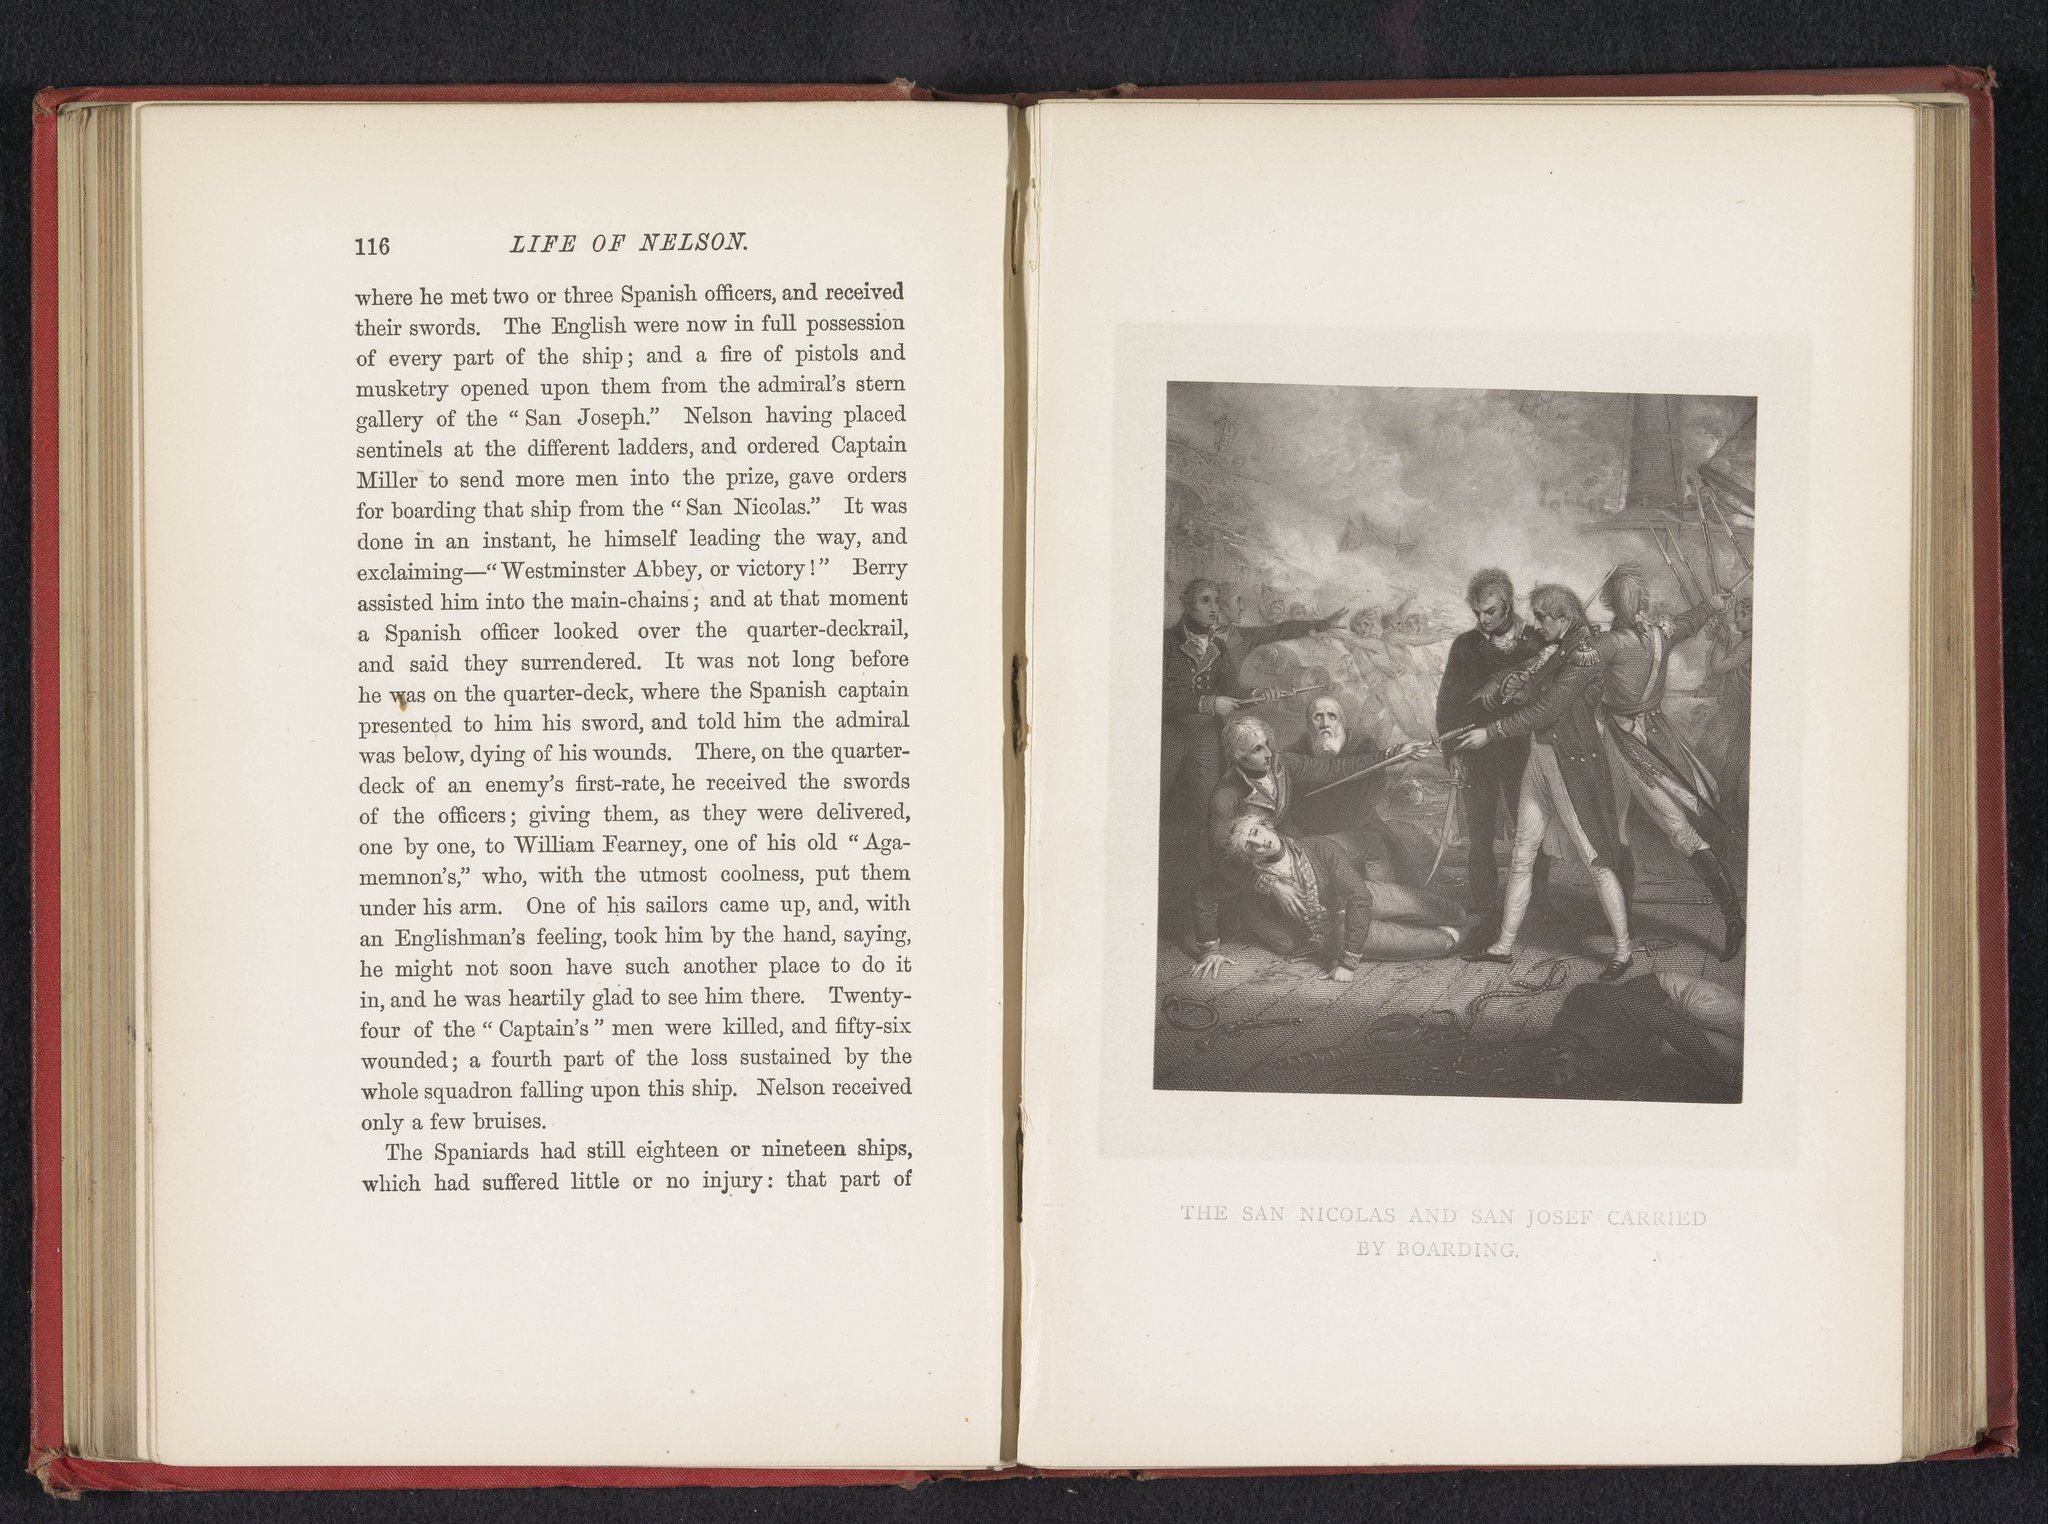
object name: page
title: Fotoreproductie van een prent van vermoedelijk de zeeslag bij Kaap Sint-Vincent in 1797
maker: Anonymous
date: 1877-1887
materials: paper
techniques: woodburytype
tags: horatio nelson (hertog van bronte), battle